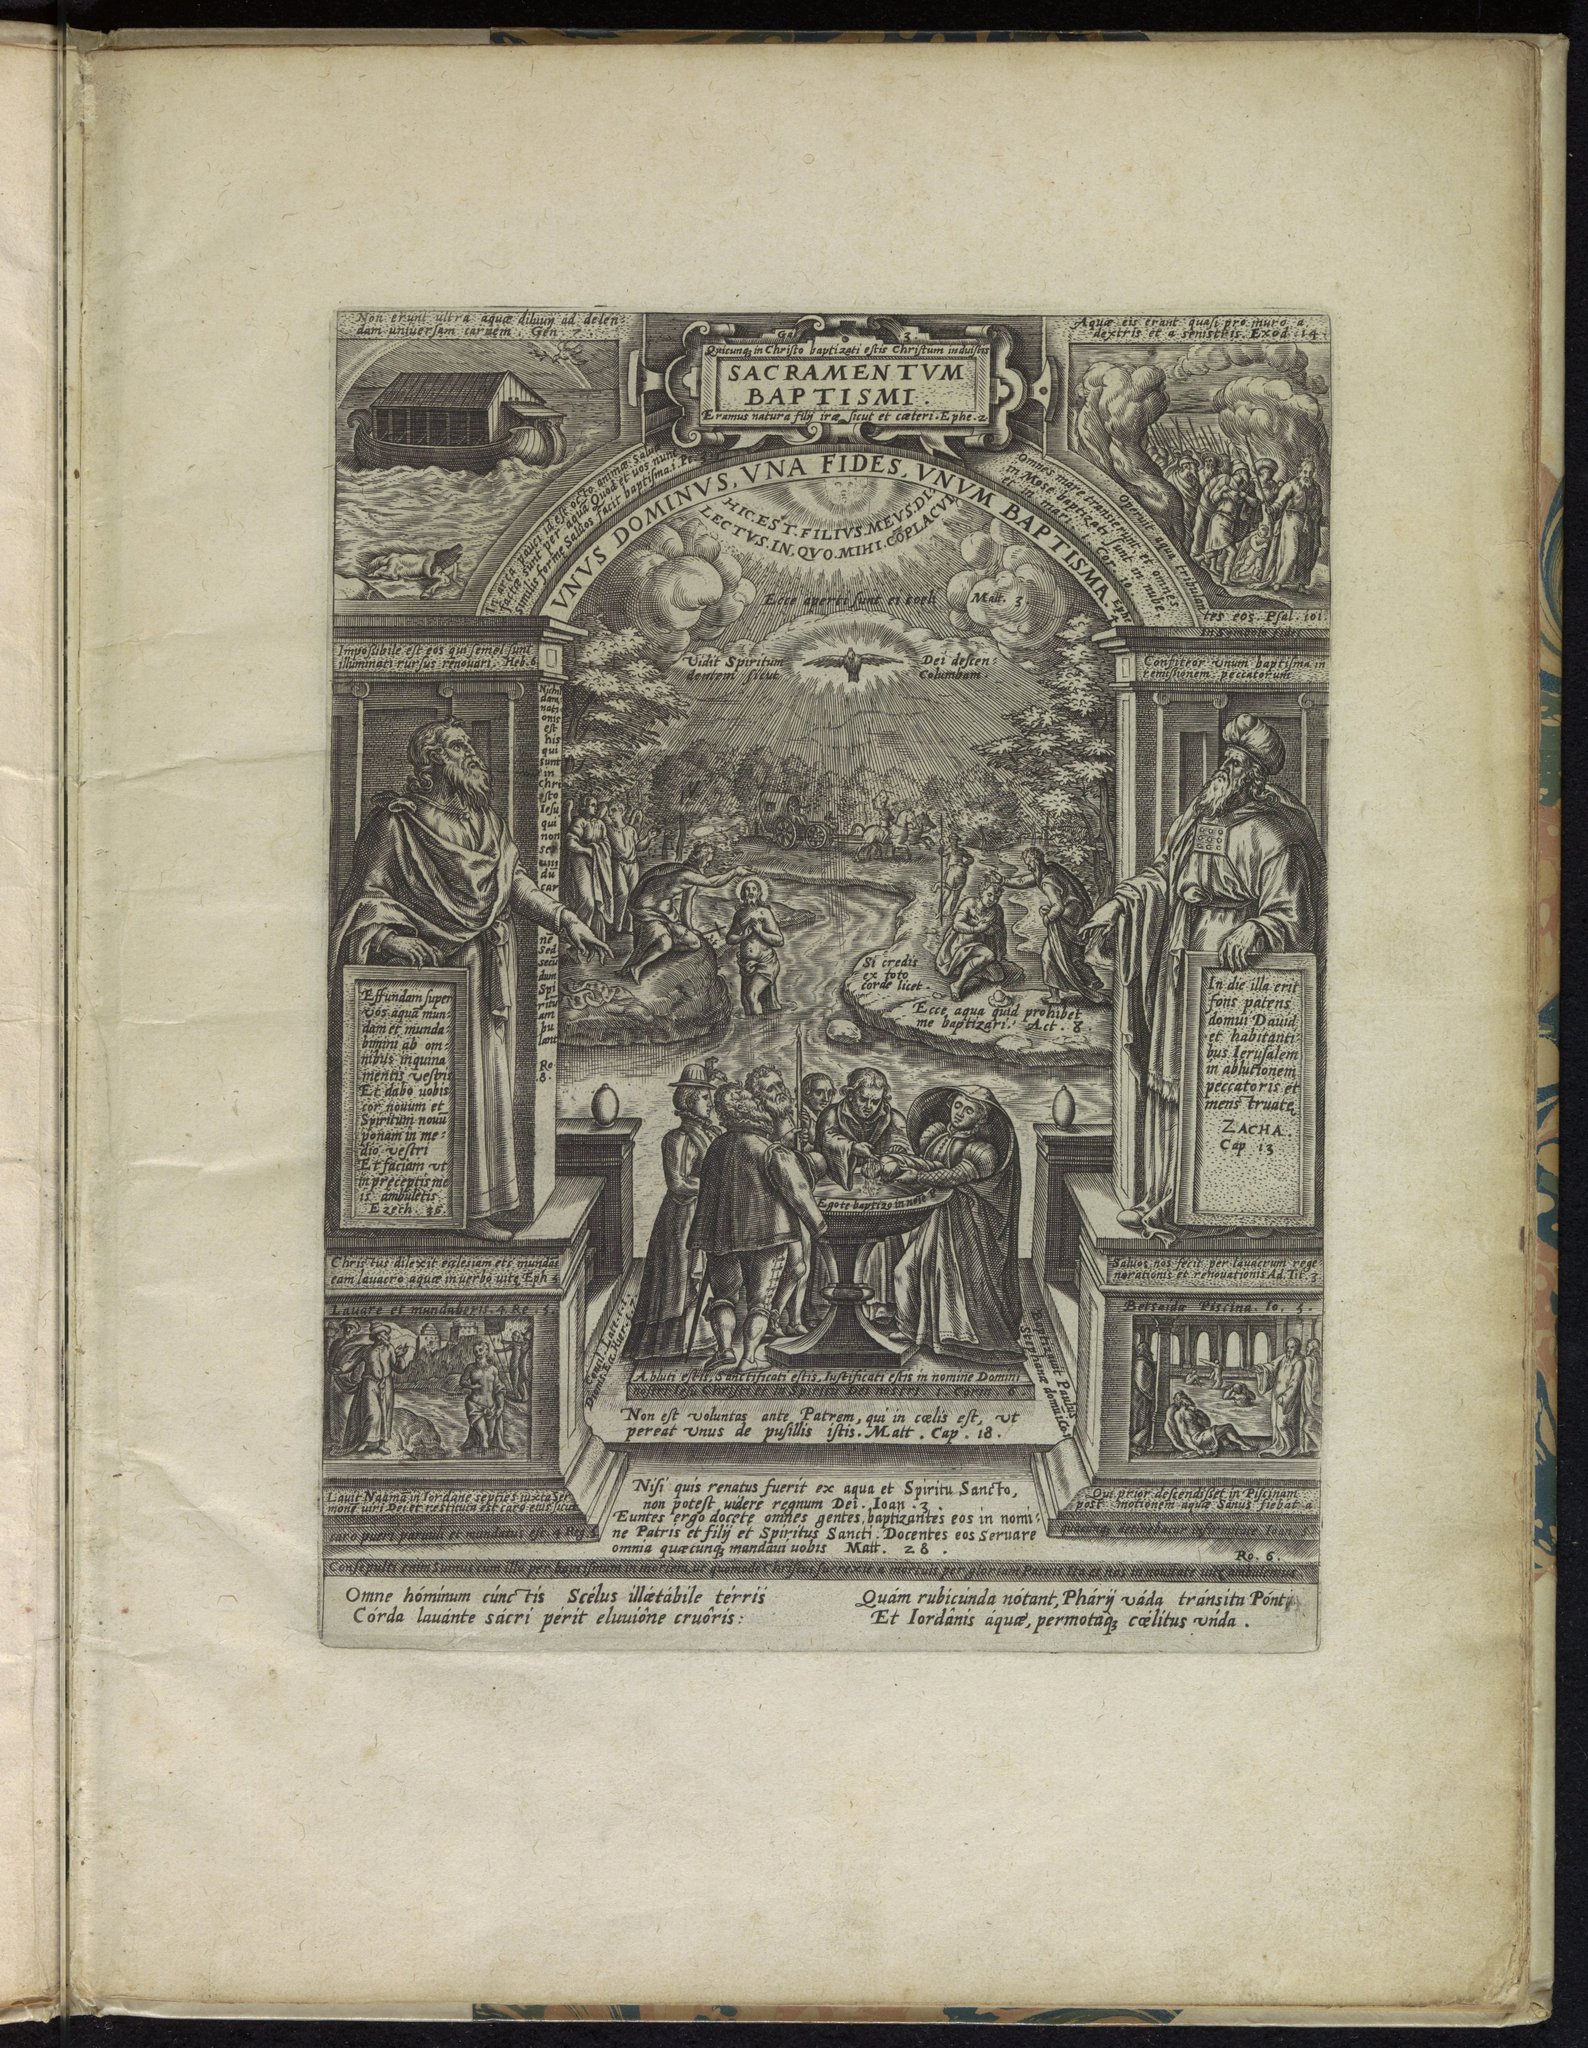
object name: print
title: Sacramentum Baptismi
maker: philips galle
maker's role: print maker, publisher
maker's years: 1537-1612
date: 1576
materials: paper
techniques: engraving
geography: antwerp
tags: the ark ~ story of noah, baptism of christ in the river jordan: john the baptist pouring out water on christ's head: the holy ghost descends, philip baptizes the eunuch, baptism, christening ceremony ~ the first of the seven sacraments, sick people lying near the pool of bethesda ~ christ healing paralytics (john 5:1-9), passage through the red sea, naaman comes to the jordan, dips himself seven times and is cured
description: Het sacrament van de doop. In het midden een voorstelling van de doop van een baby bij een doopvont. Op de achtergrond een landschap met de doop van Christus door Johannes en de doop van de kamerling door Filippus. Rondom voorstellingen van Bijbelverhalen die te maken hebben met water. Linksboven de ark van Noach, rechtsboven de doortocht door de Rode Zee, rechtsonder Christus geneest een verlamde man bij het bad van Betzata en linksonder de genezing van Naäman. Links en rechts de profeten Ezechiel en Zacharia. In de voorstelling diverse Bijbelteksten in het Latijn. Onder de voorstelling een vierregelig vers in het Latijn. Deze prent maakt deel uit van een album.